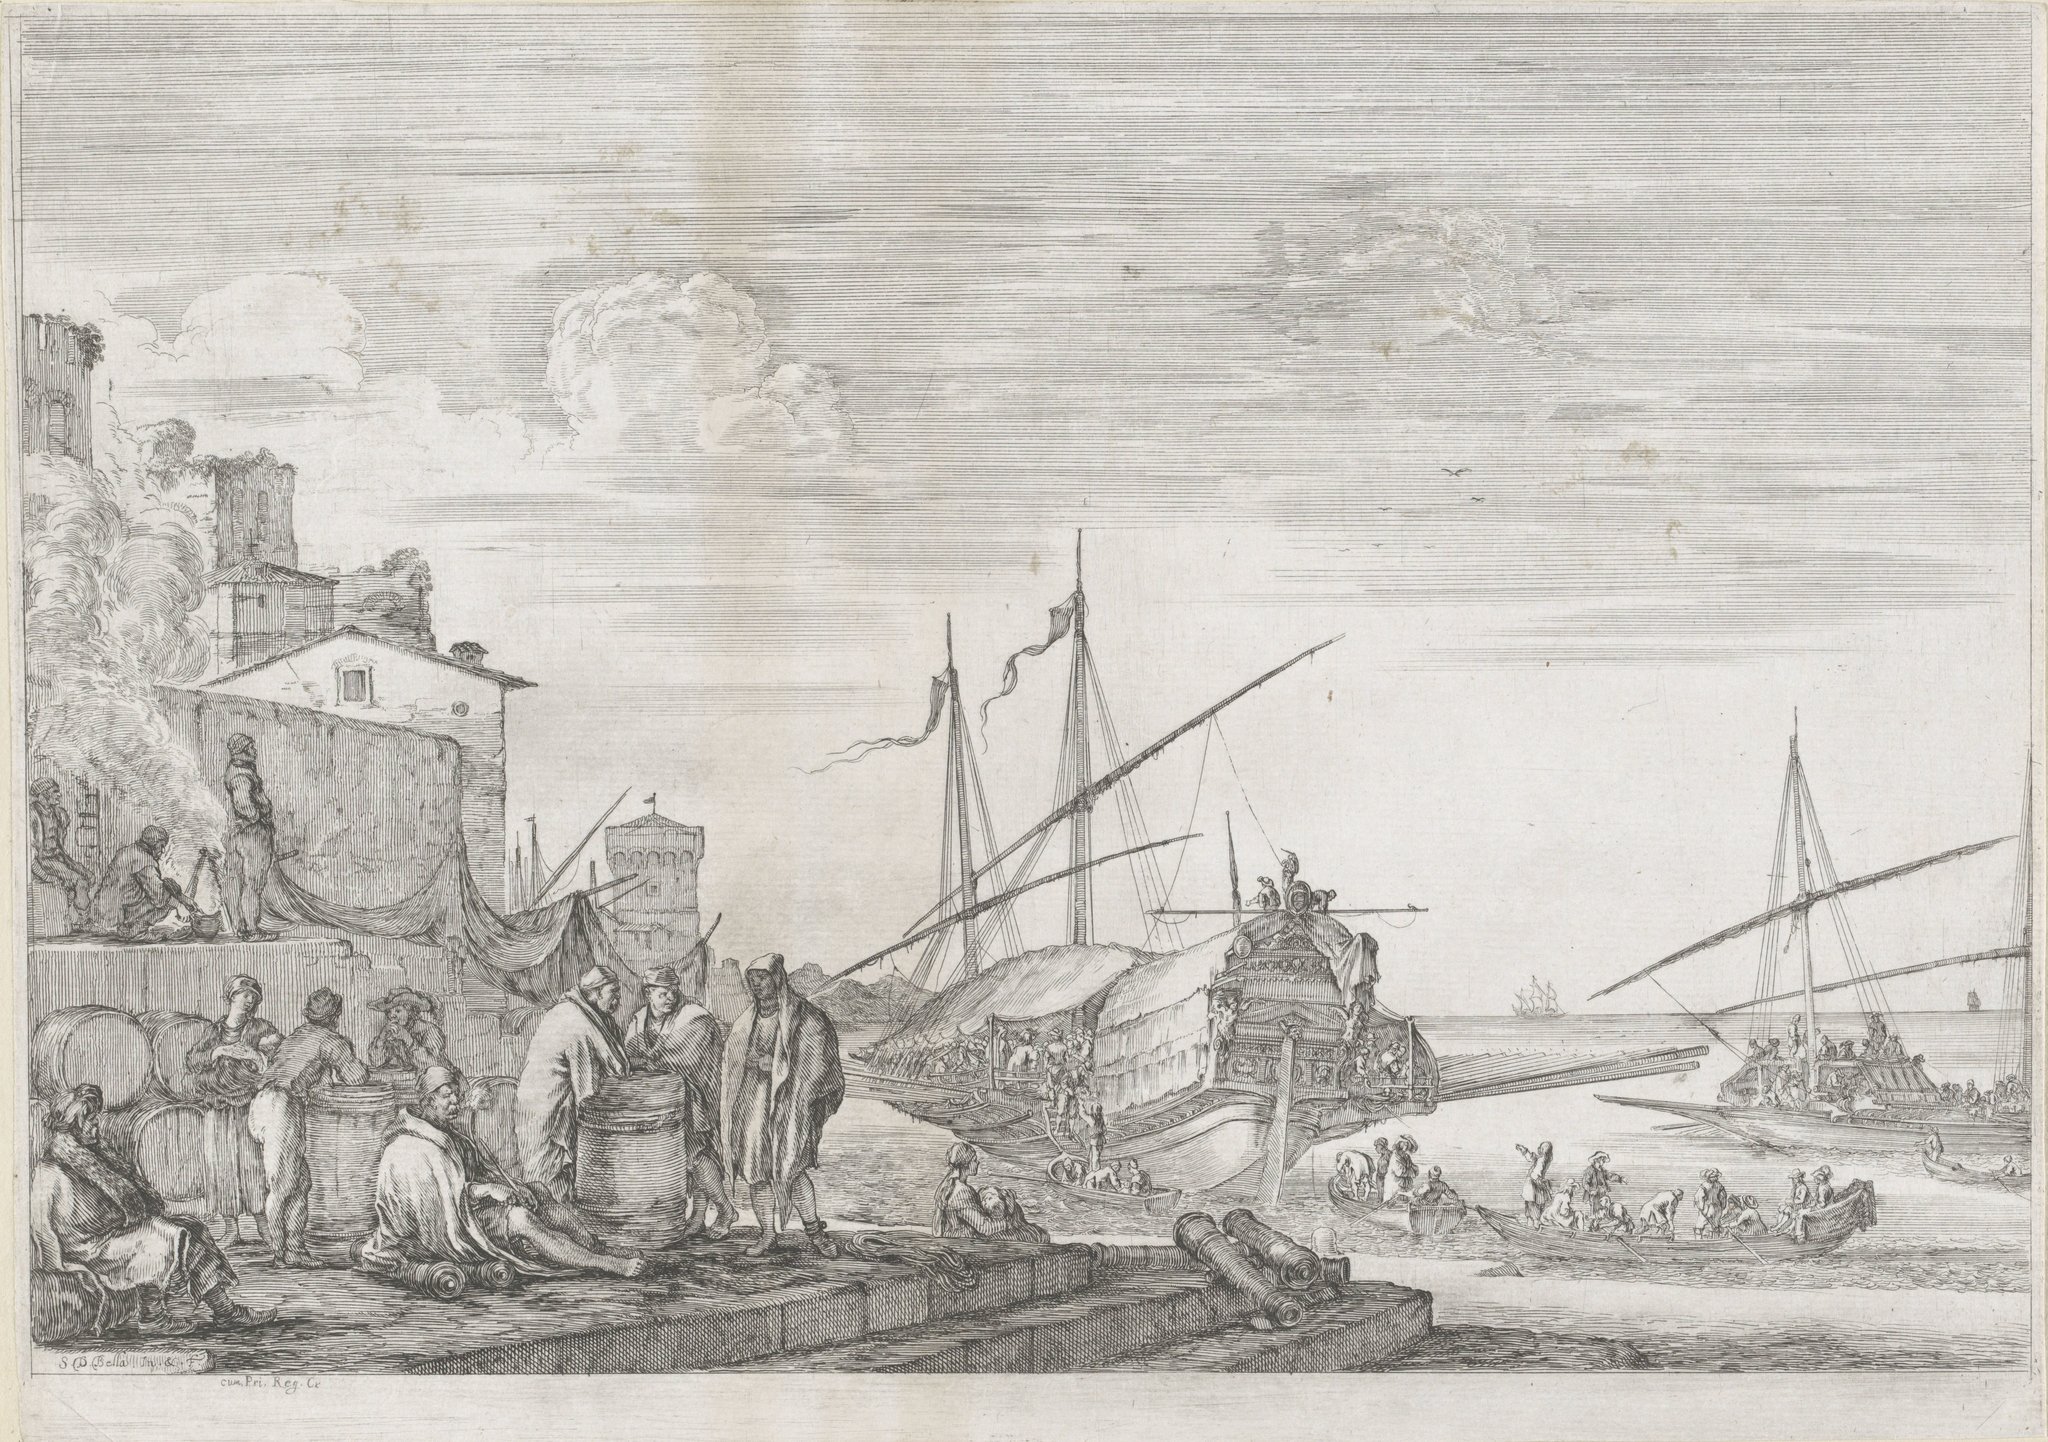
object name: print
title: Twee galeischepen in de haven van Livorno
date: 1655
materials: paper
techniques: etching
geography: italy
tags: harbour, dock labourer, ships (in general), merchant, salesman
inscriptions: collector's mark: Lugt 240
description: Zicht op de haven van Livorno met twee galeischepen. Op de kade links staan havenarbeiders en handelaren. Op de achtergrond links gebouwen en een toren aan de kust.